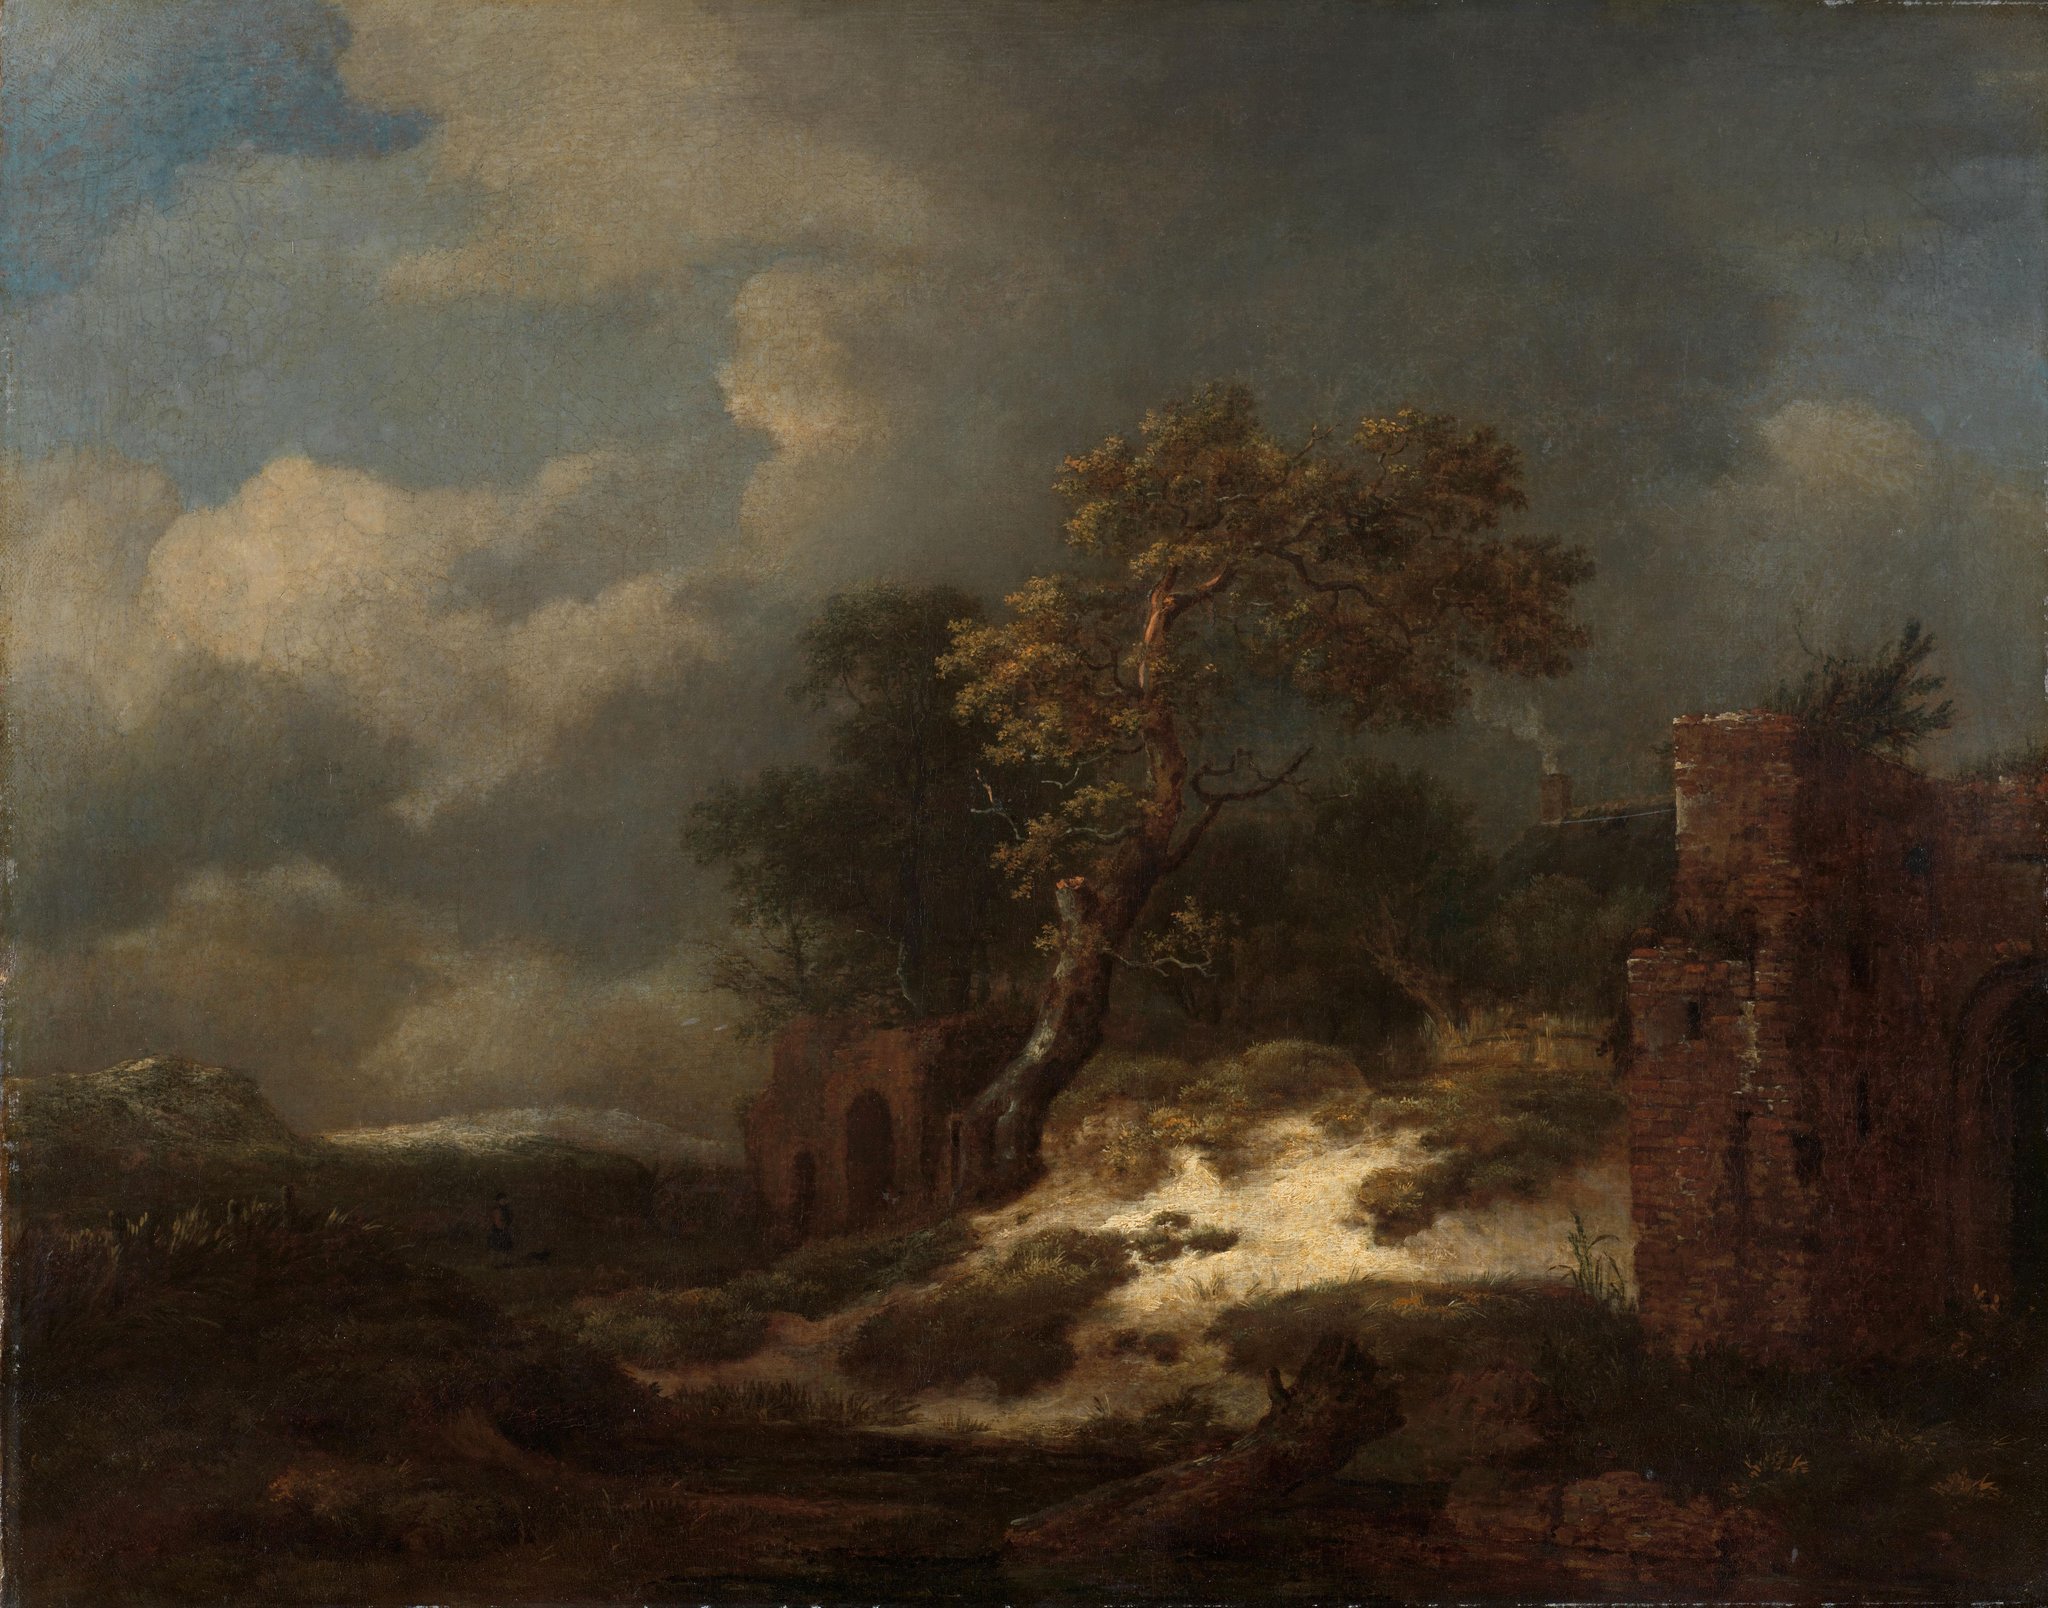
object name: painting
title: Landscape with Ruins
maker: jacob isaacksz van ruisdael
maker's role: draughtsman, painter, print maker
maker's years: 1628-1682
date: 1650-1682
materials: canvas, oil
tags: ruin of a building ~ architecture, landscape with ruins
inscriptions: signature: ‘JvRuisdael’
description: Duinlandschap met bakstenen ruïnes, op de voorgrond een waterplas met een afgebroken boomstam.